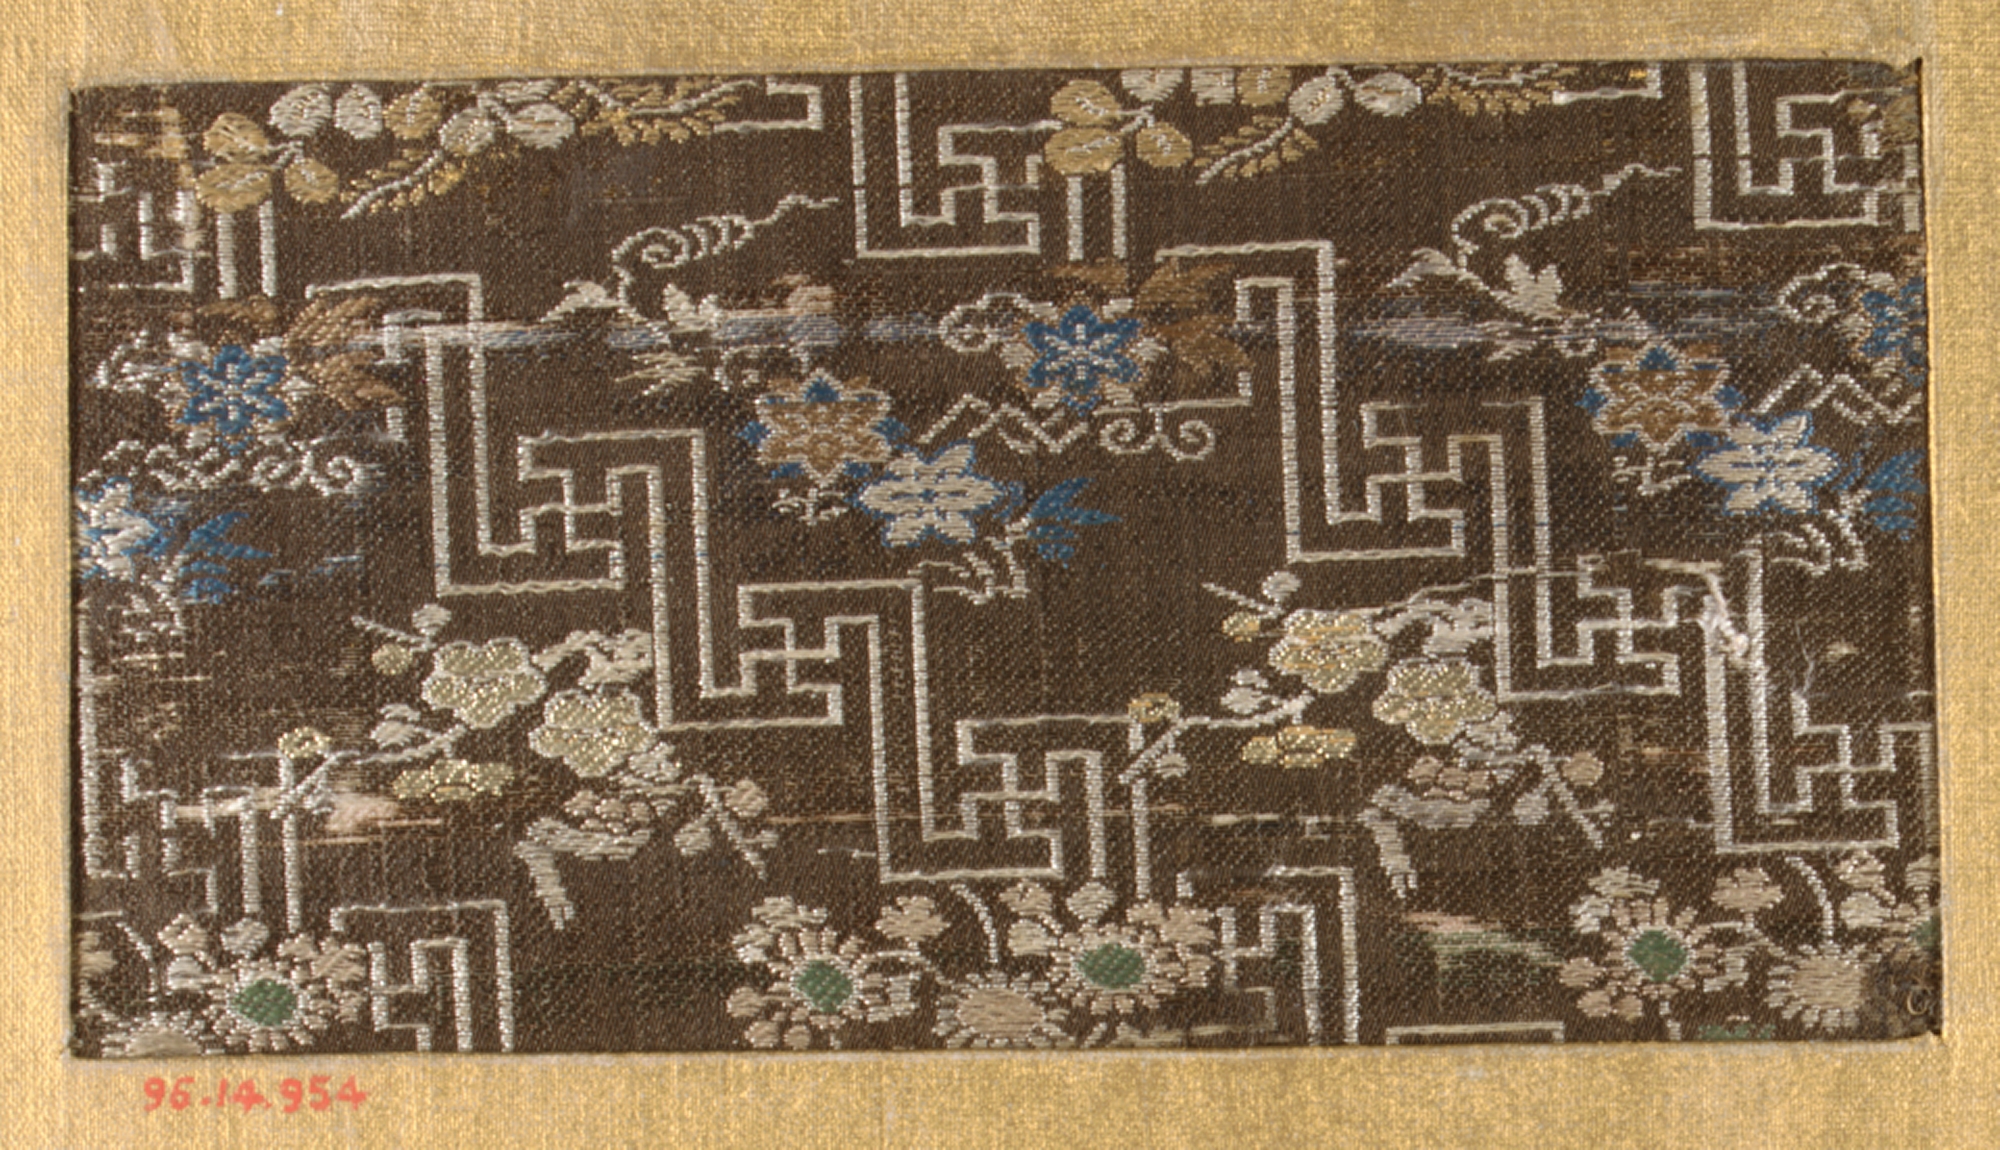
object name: piece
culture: japanese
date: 1701-1900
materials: silk